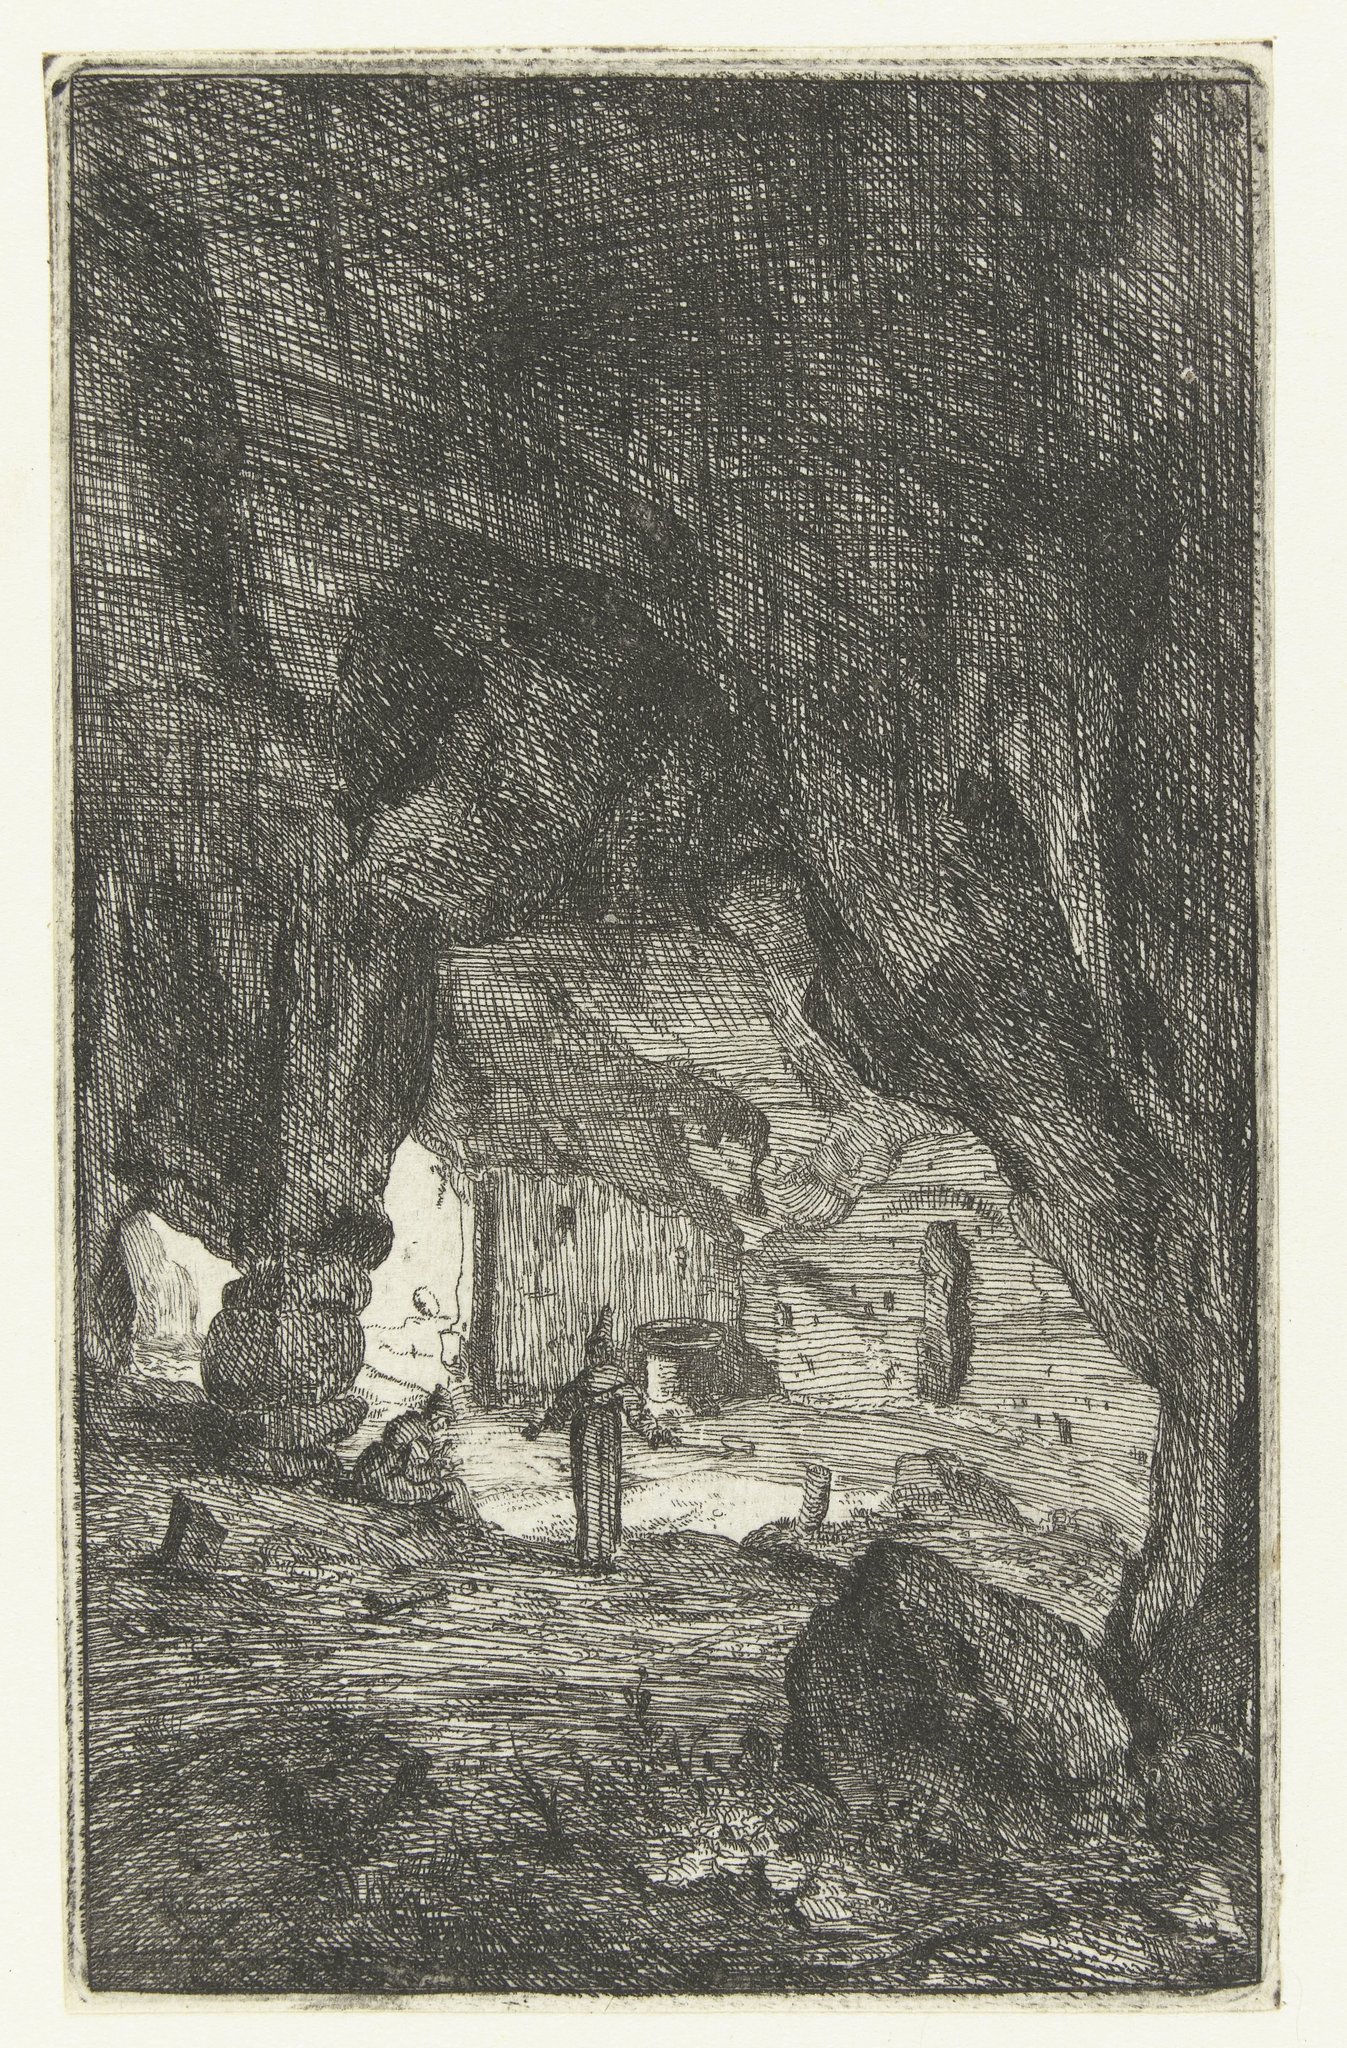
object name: print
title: Verscheijden Vervallen gebouwe Soo binnen als buyten Romen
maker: bartholomeus breenbergh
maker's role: draughtsman, print maker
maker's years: 1599-1657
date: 1639-1640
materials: paper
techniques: etching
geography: netherlands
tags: cave, grotto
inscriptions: collector's mark: Lugt 240